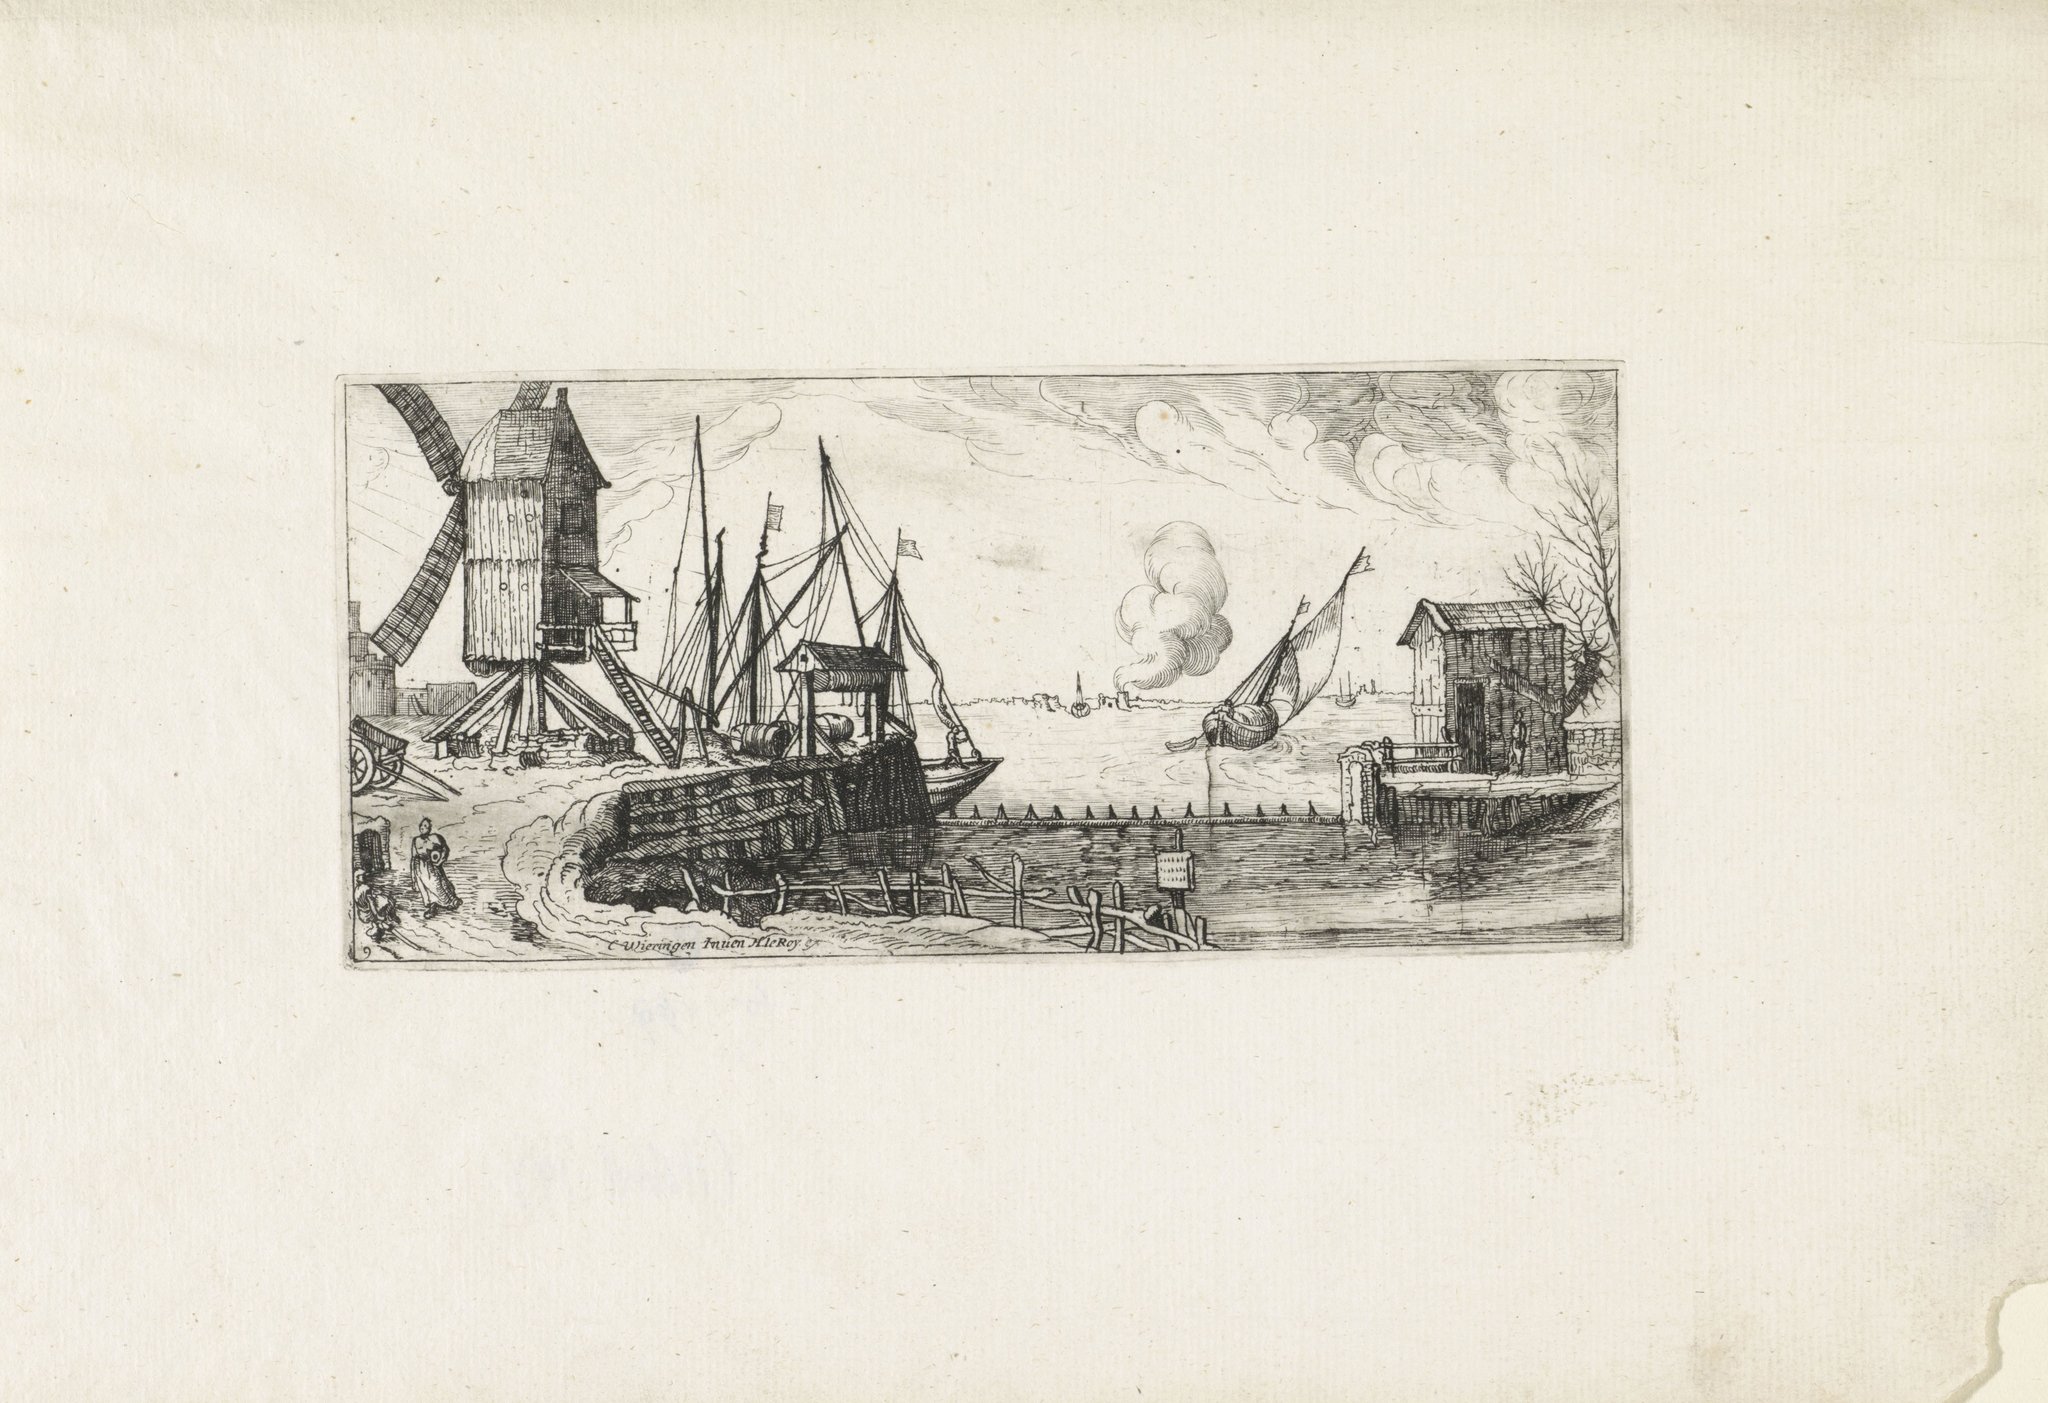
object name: print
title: Schepen voor de gesloten ingang van een haven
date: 1614-1618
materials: paper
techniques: etching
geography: haarlem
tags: harbour, windmill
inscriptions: collector's mark: Lugt 2228, collector's mark: Lugt 2760